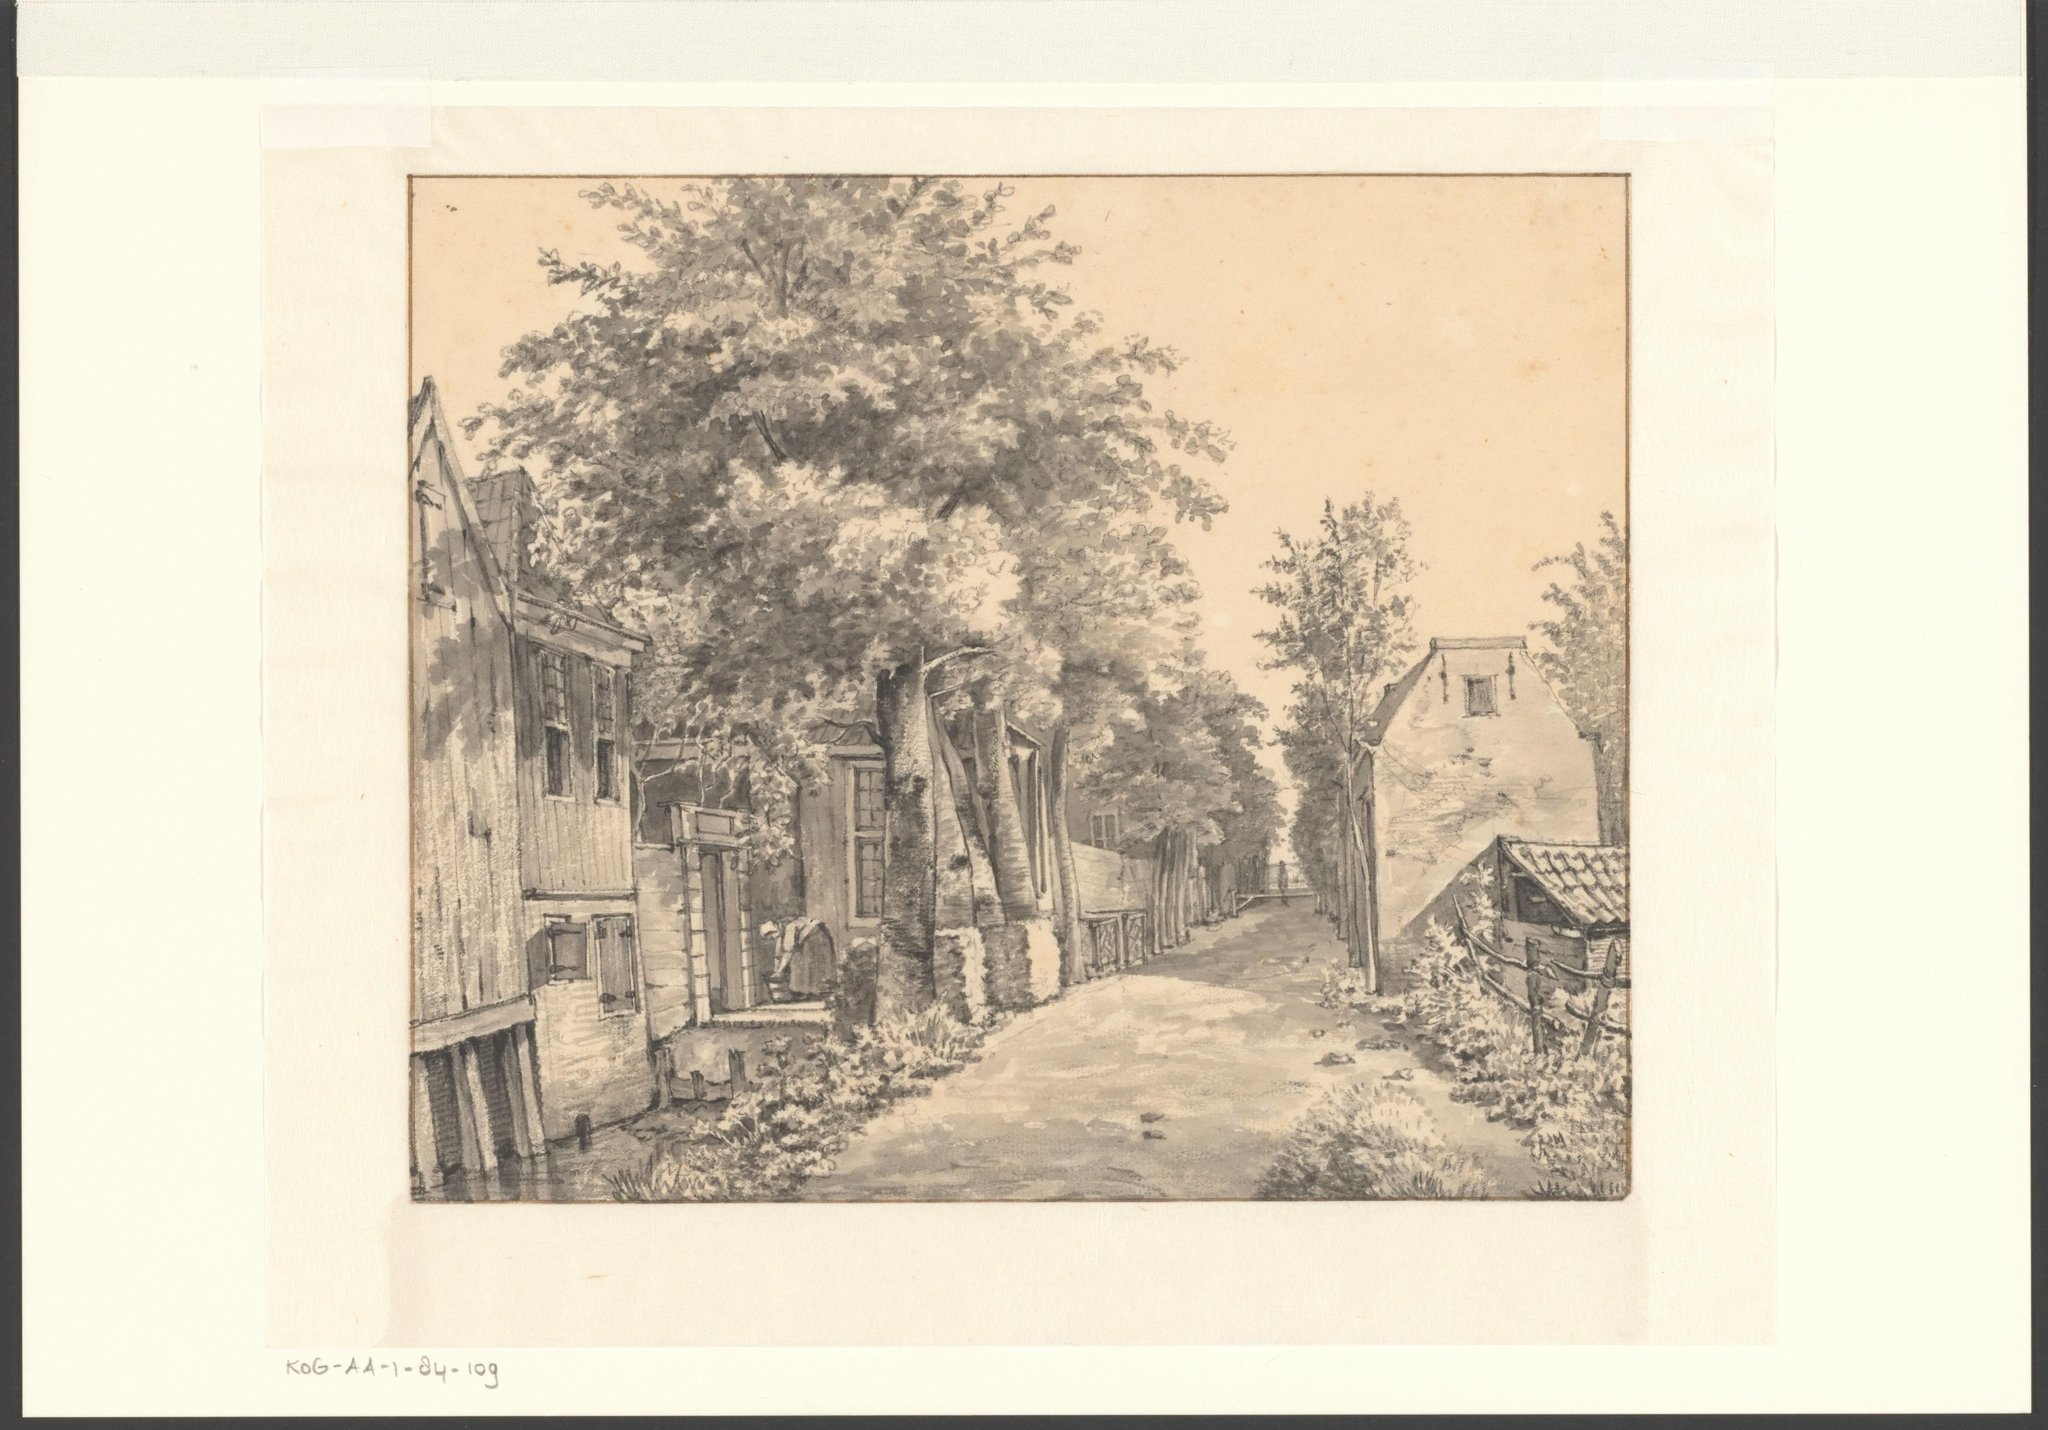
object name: drawing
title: Gezicht op de Schagerlaan gezien naar de Ringdijk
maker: gerrit lamberts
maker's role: bookseller, draughtsman, print maker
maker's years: 1776-1850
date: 1817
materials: chalk, ink, paper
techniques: brush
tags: village, lane, alley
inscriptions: signature, date and inscription: ‘Gezigt in de (...) G. Lamberts. 1817.’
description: Onderwerpsrubriek binnen de Atlas Amsterdam: Diemer- of Watergraafsmeer.